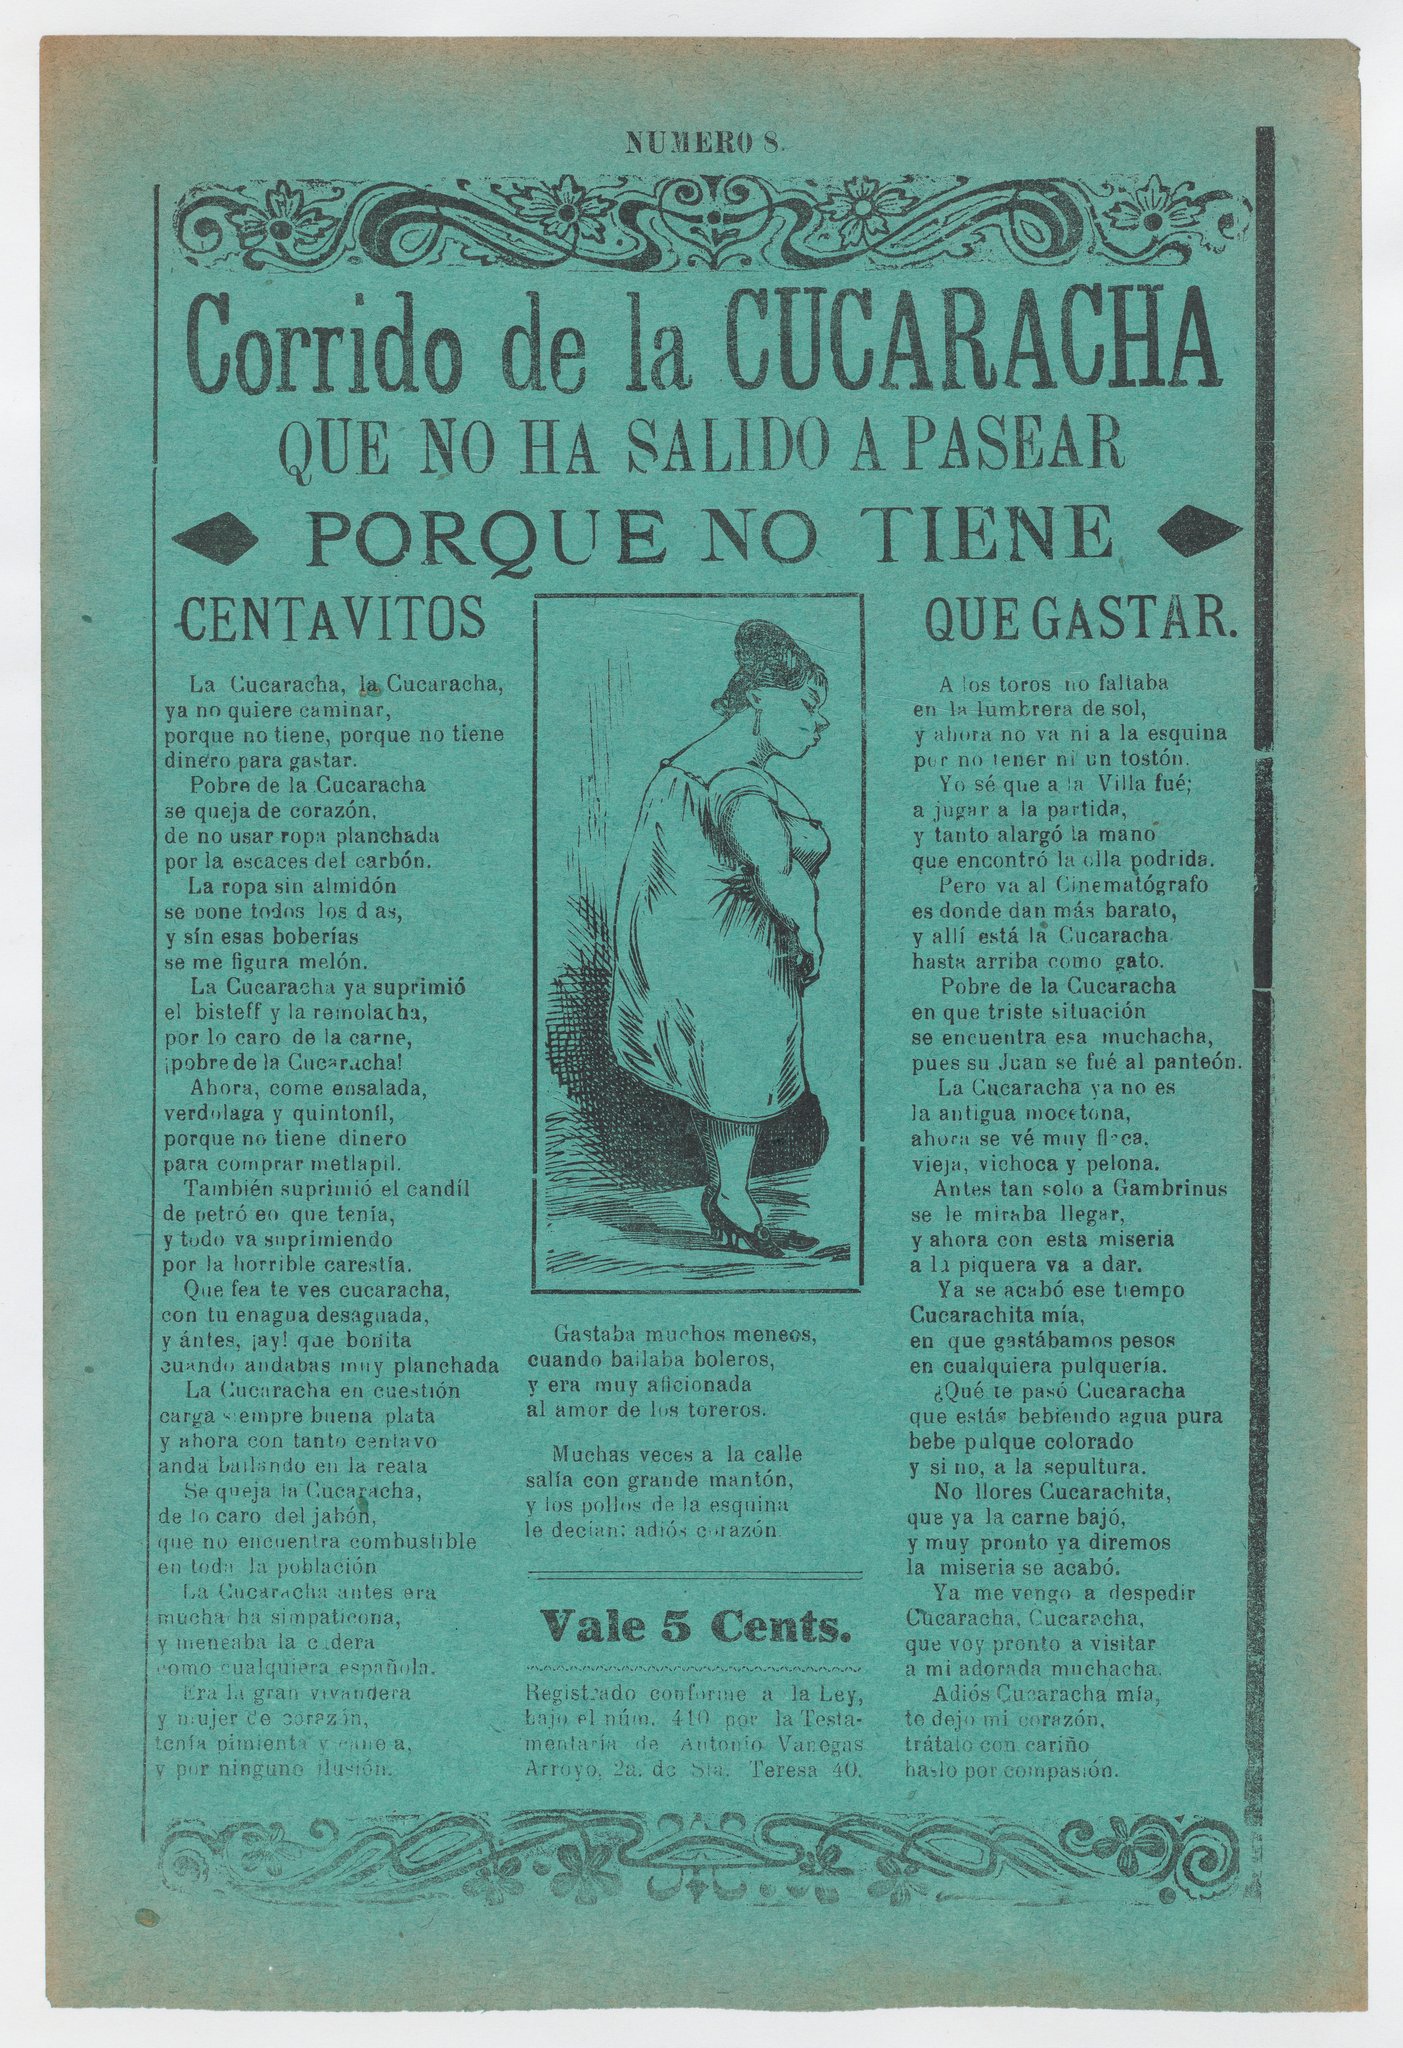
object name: print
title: Broadsheet with a ballad about camp life hardships for women, profile of a woman looking downcast wearing a slip and heels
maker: josé guadalupe posada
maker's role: artist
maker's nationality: mexican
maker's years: 1852-1913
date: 1918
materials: paper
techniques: letterpress, lithography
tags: women